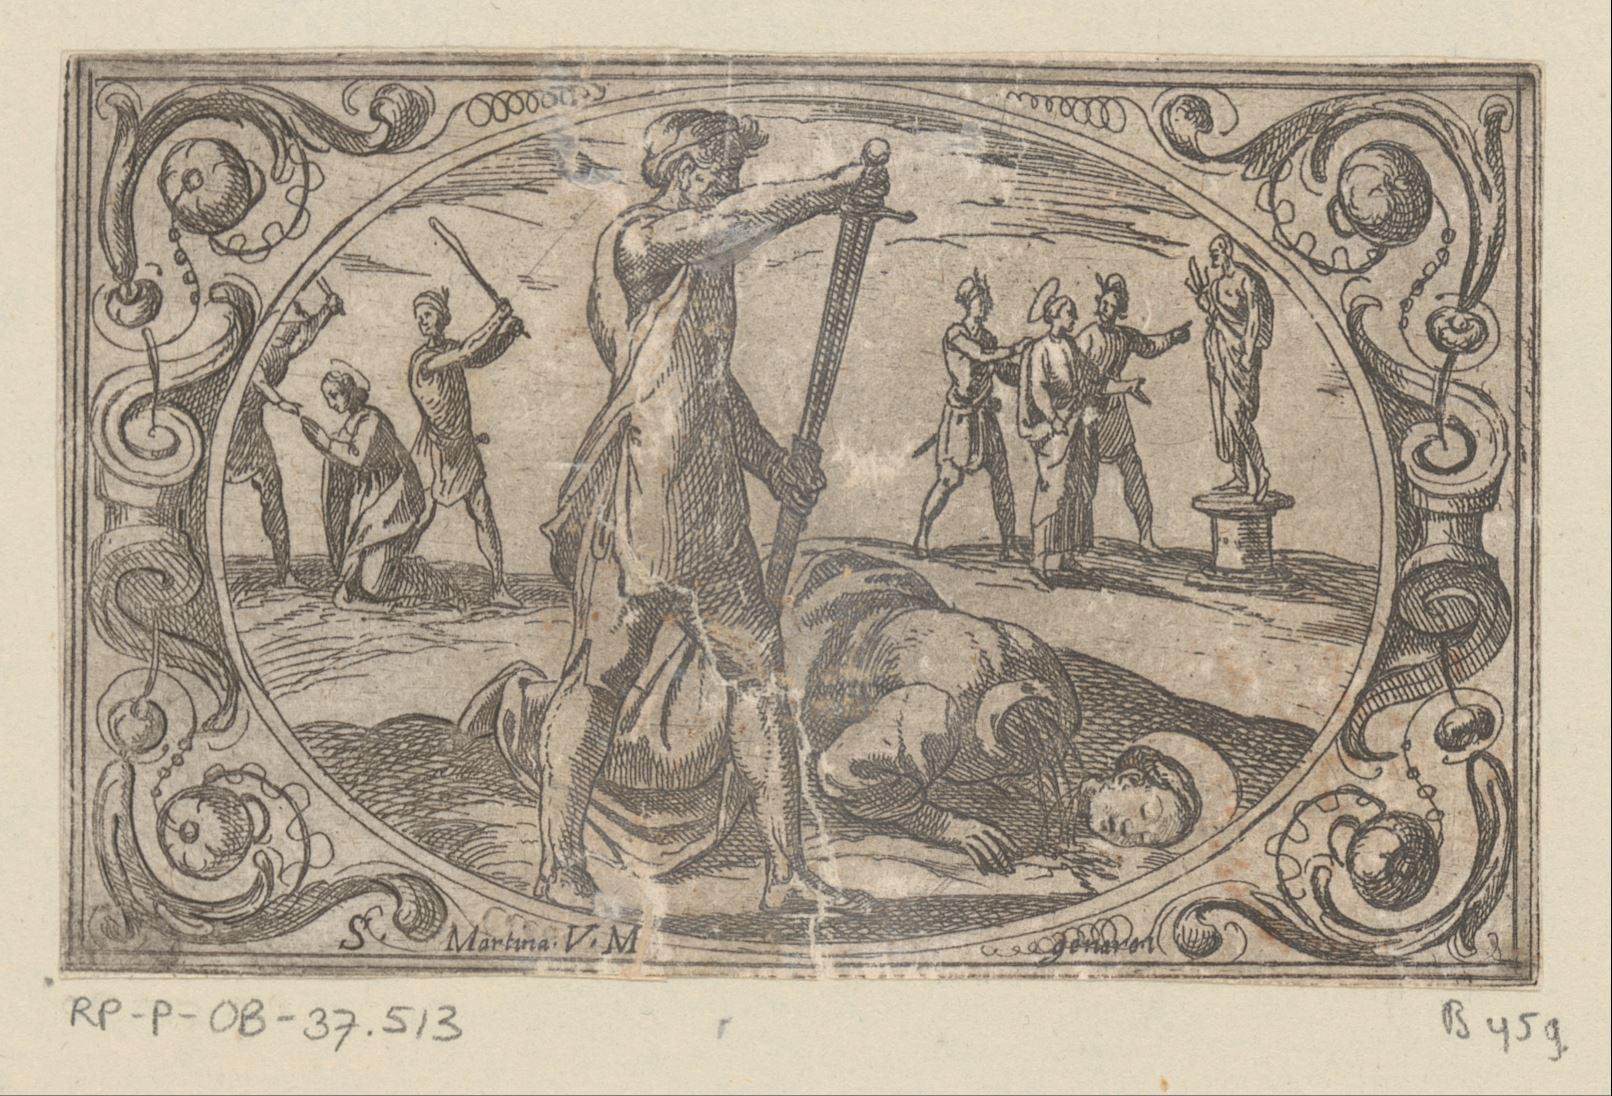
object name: print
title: Romeinse martelaressen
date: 1565-1630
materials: paper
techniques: etching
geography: rome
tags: martyr(s) (often with palm-branches) - qq - female martyr, violent death by beheading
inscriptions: collector's mark: Lugt 240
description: Deze prent maakt deel uit van een reeks van 73 prenten (+ titelprent) met voorstellingen van Romeinse martelaressen.